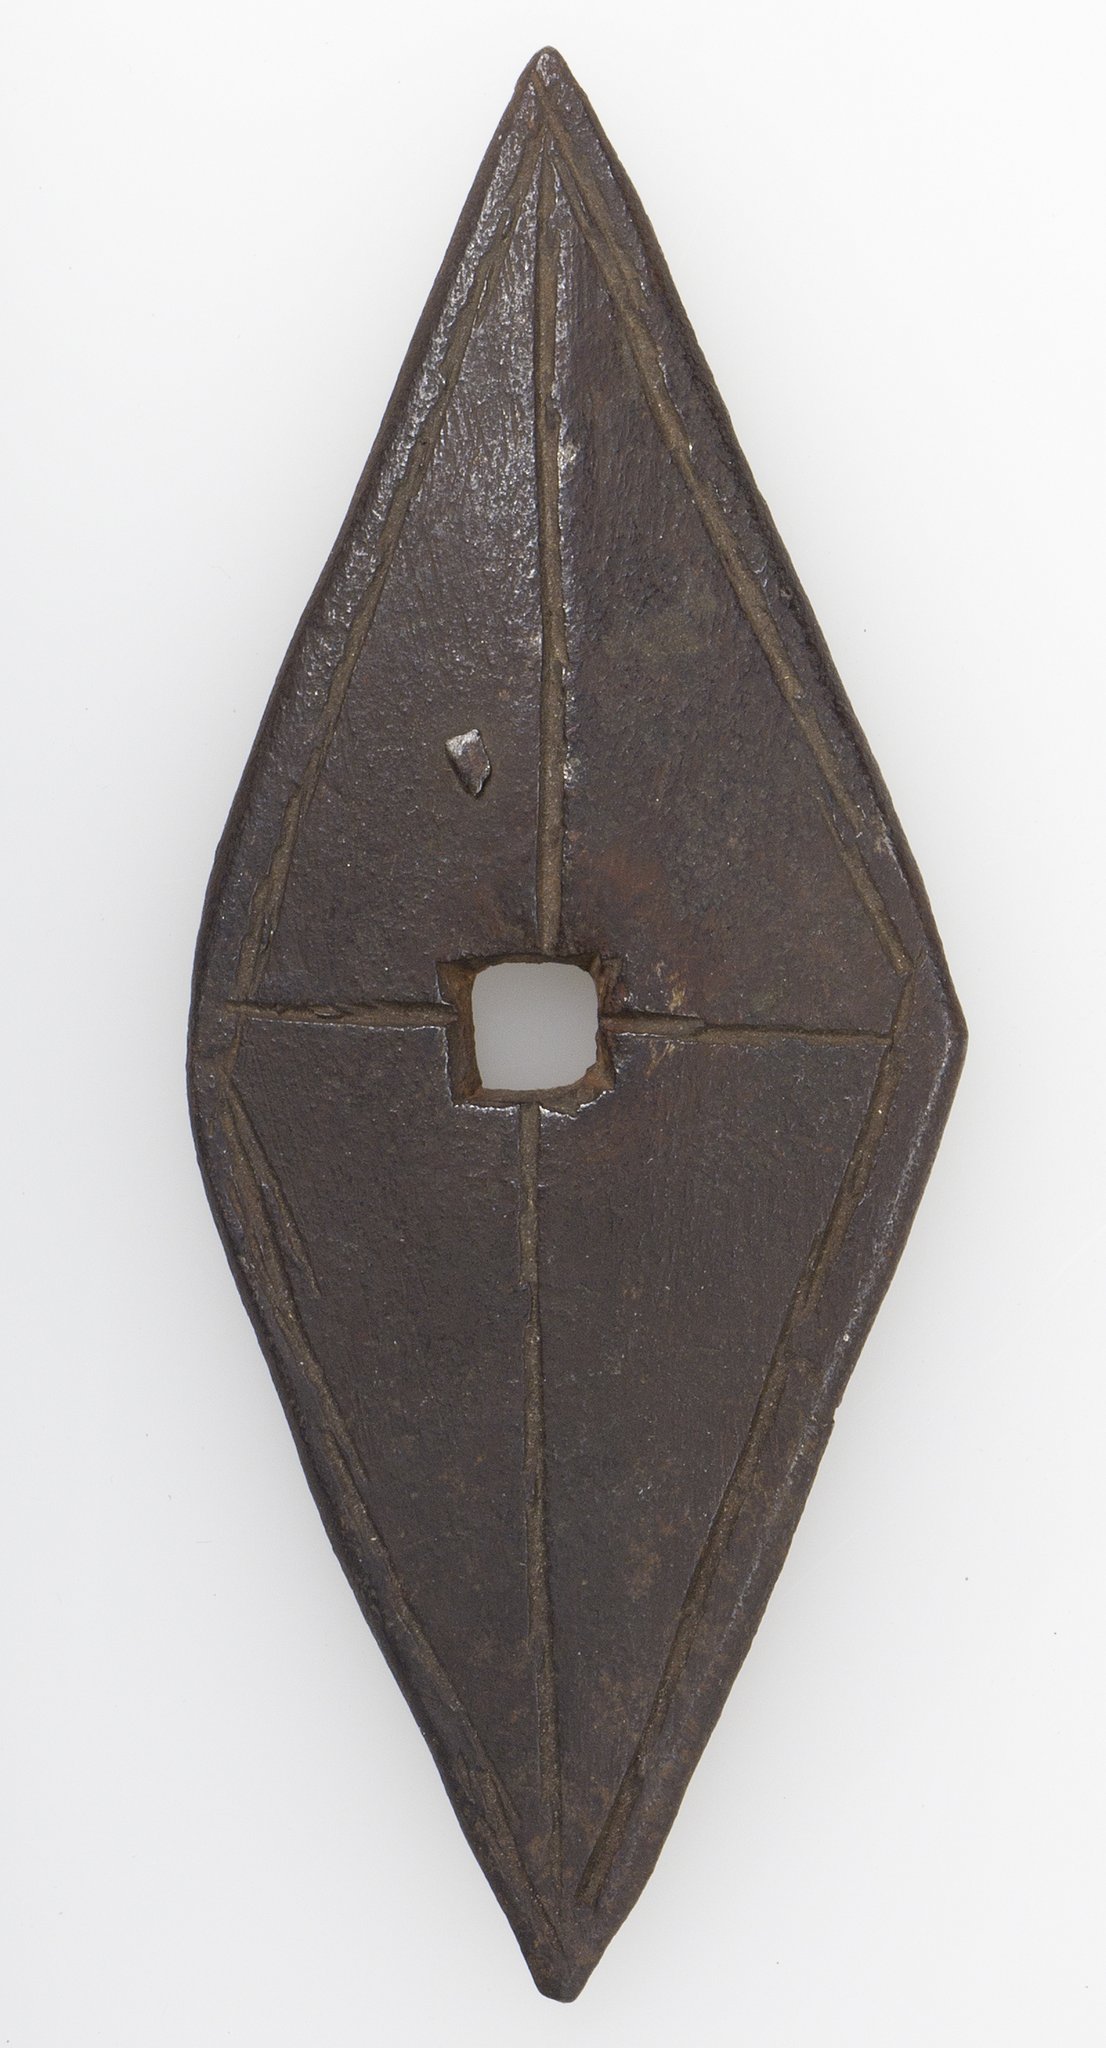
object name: plate and nail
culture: european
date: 1401-1600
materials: iron